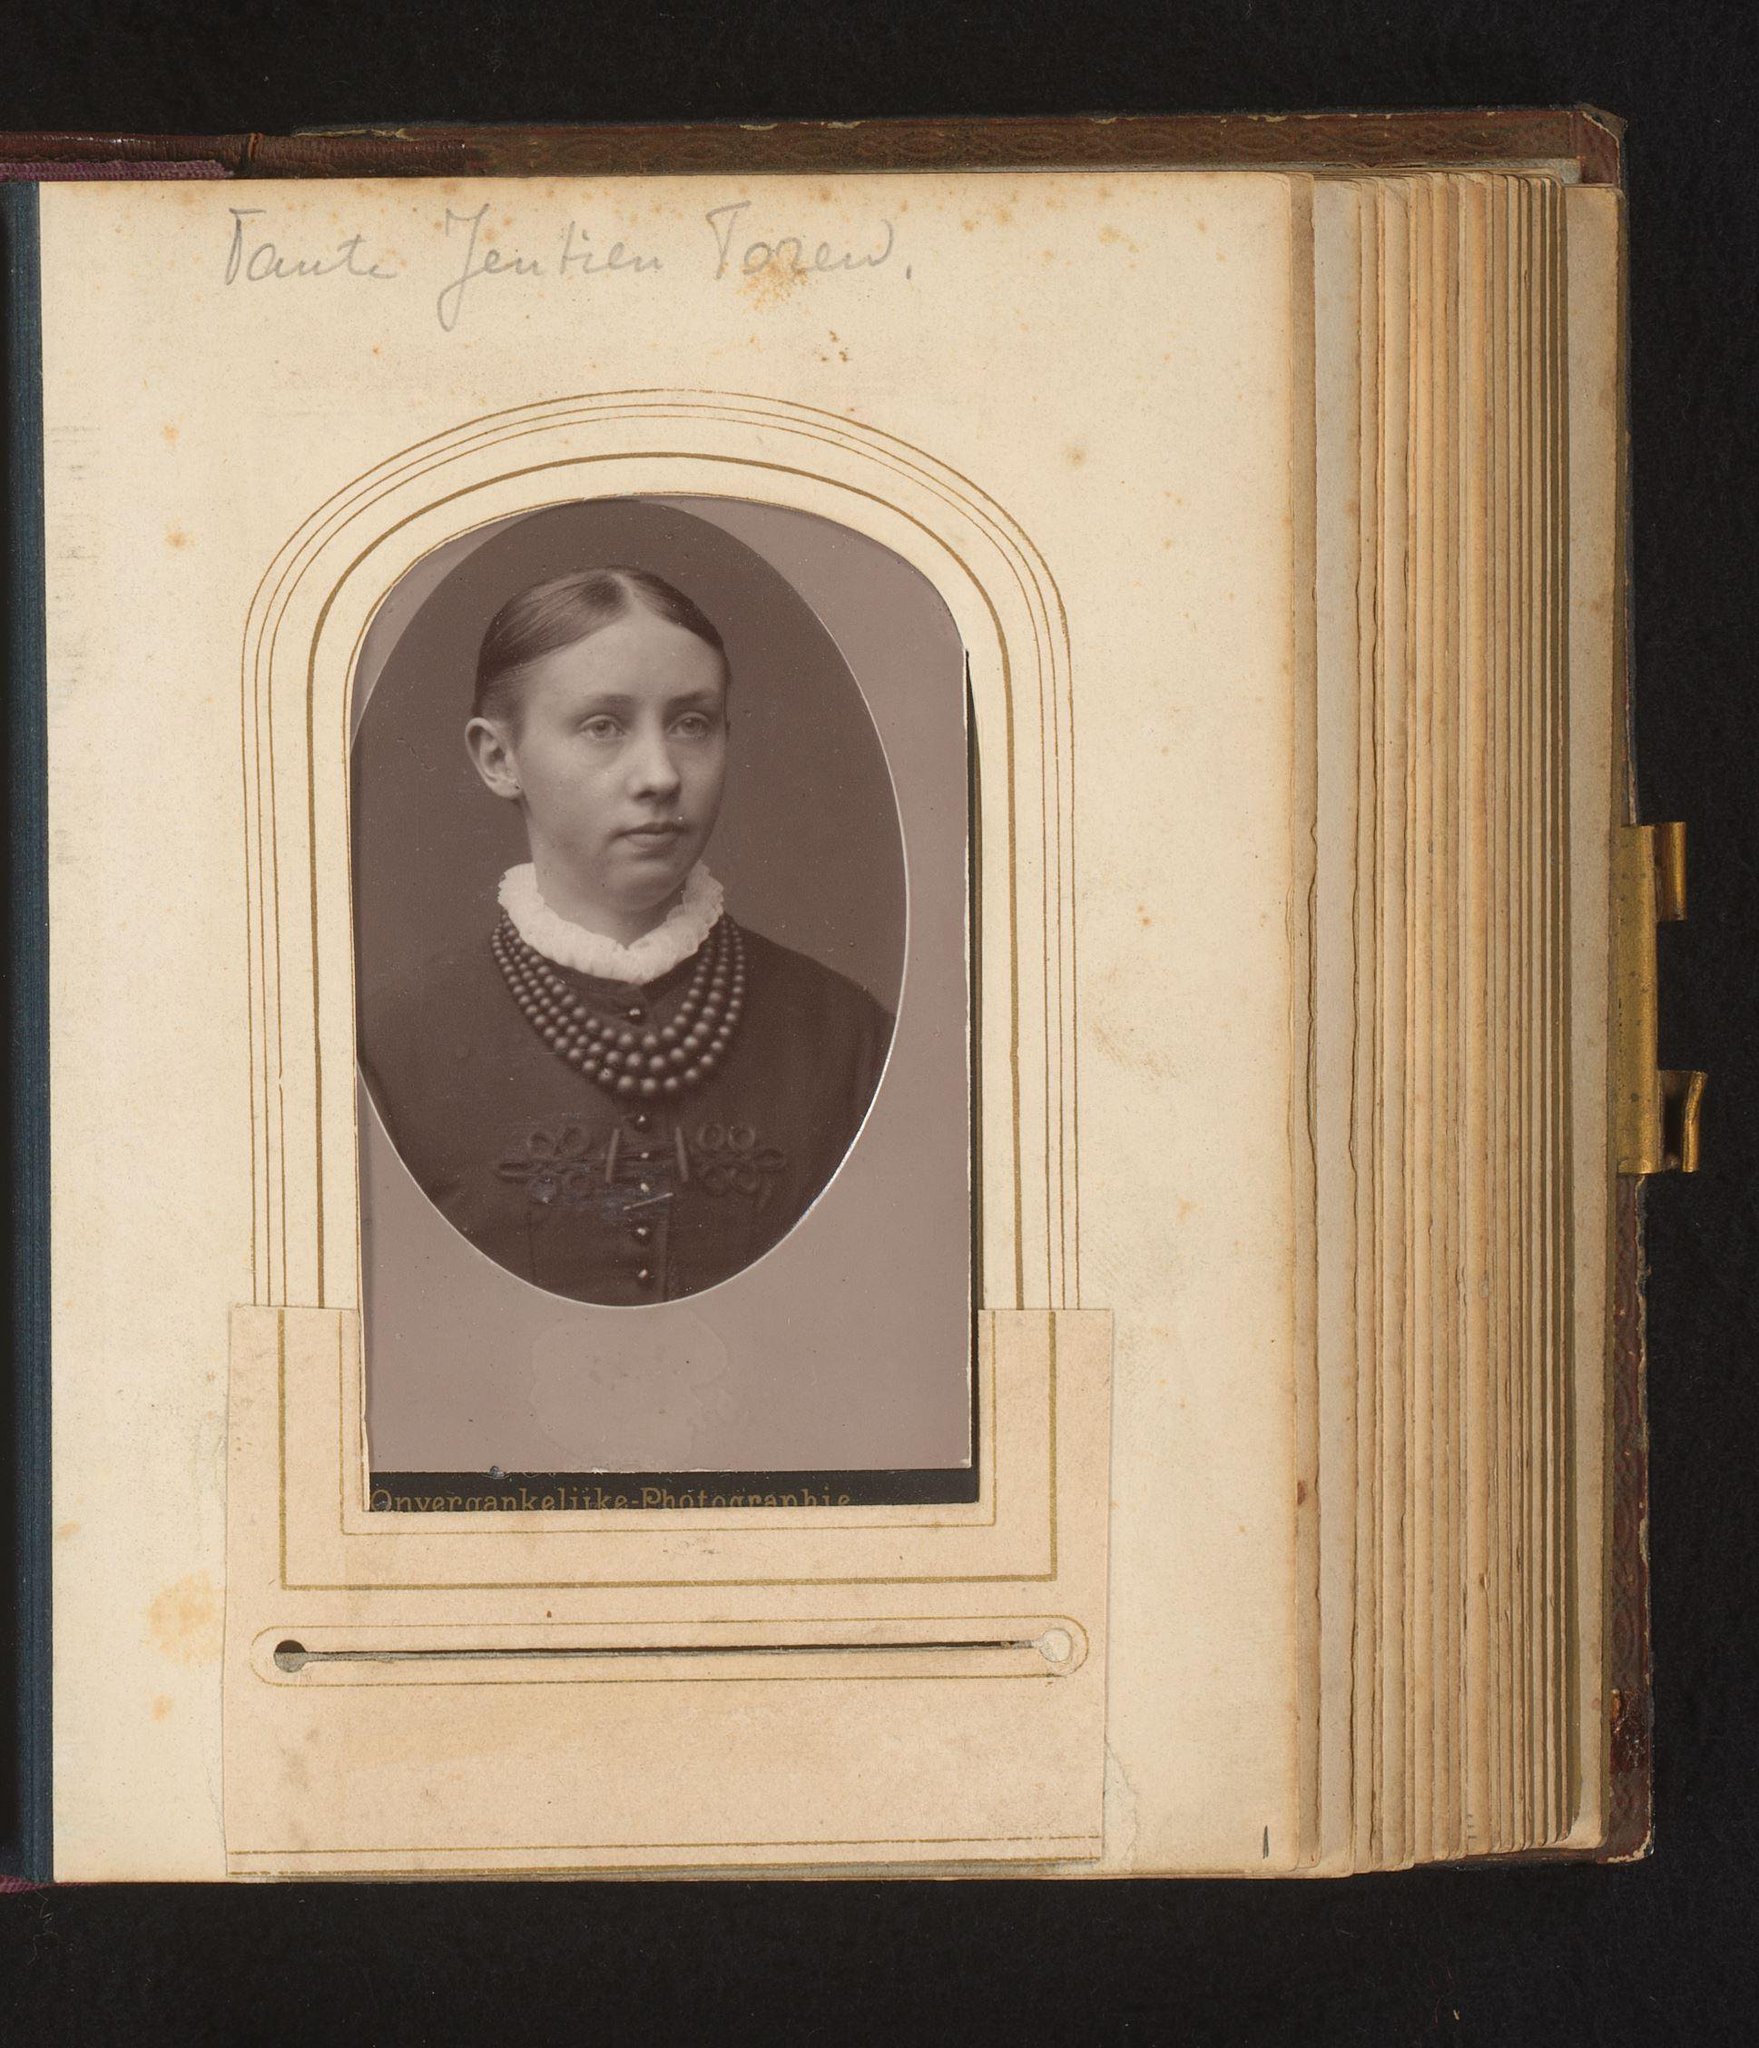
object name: carte de visite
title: Portret van een vrouw, aangeduid als Jantien Toren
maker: ed. radermacher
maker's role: fotograaf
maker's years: 1839-1908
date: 1871-1893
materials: cardboard, paper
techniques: carbon print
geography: groningen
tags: historical persons - bb - woman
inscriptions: annotation: ‘Tante Jantien Toren’, inscription: ‘Ed. Radermacher/ PHOTOGRAPHIE/ Rotterdam/ KRUISKADE/ Hoek Kerklaan.’